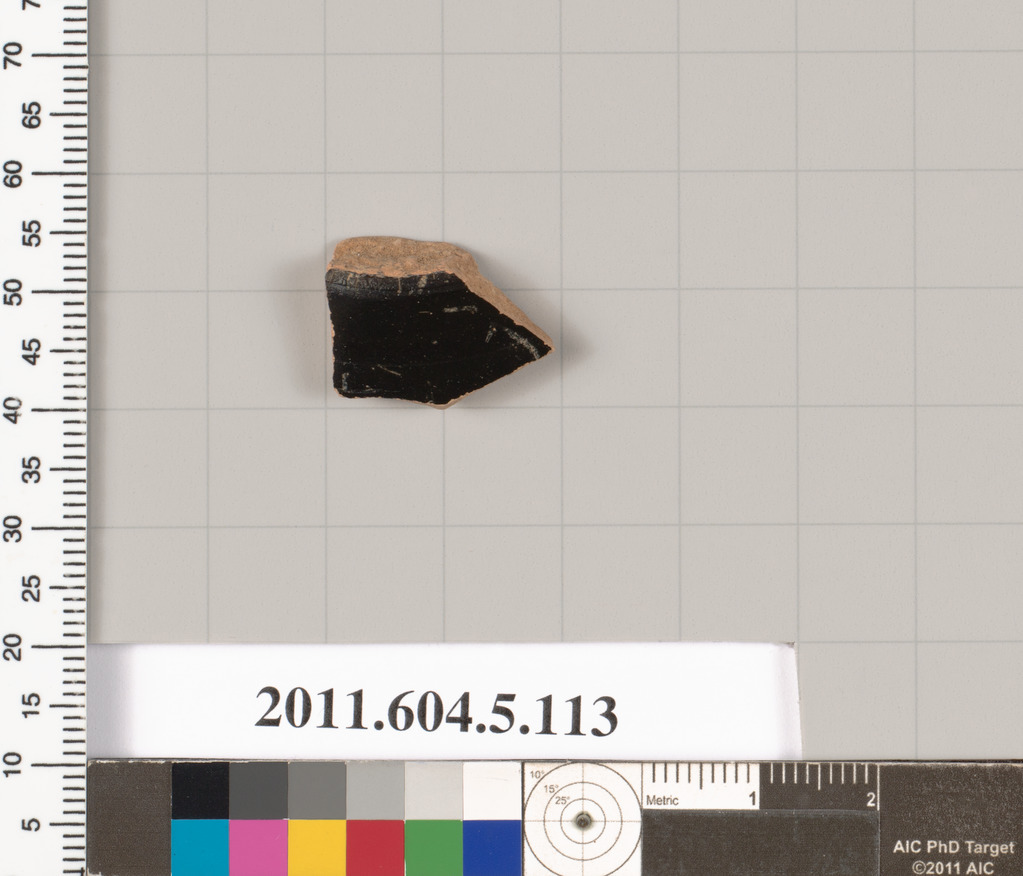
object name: kylix fragment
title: Terracotta fragment of a stemless kylix (drinking cup)?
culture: greek, attic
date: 470-450 BCE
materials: terracotta